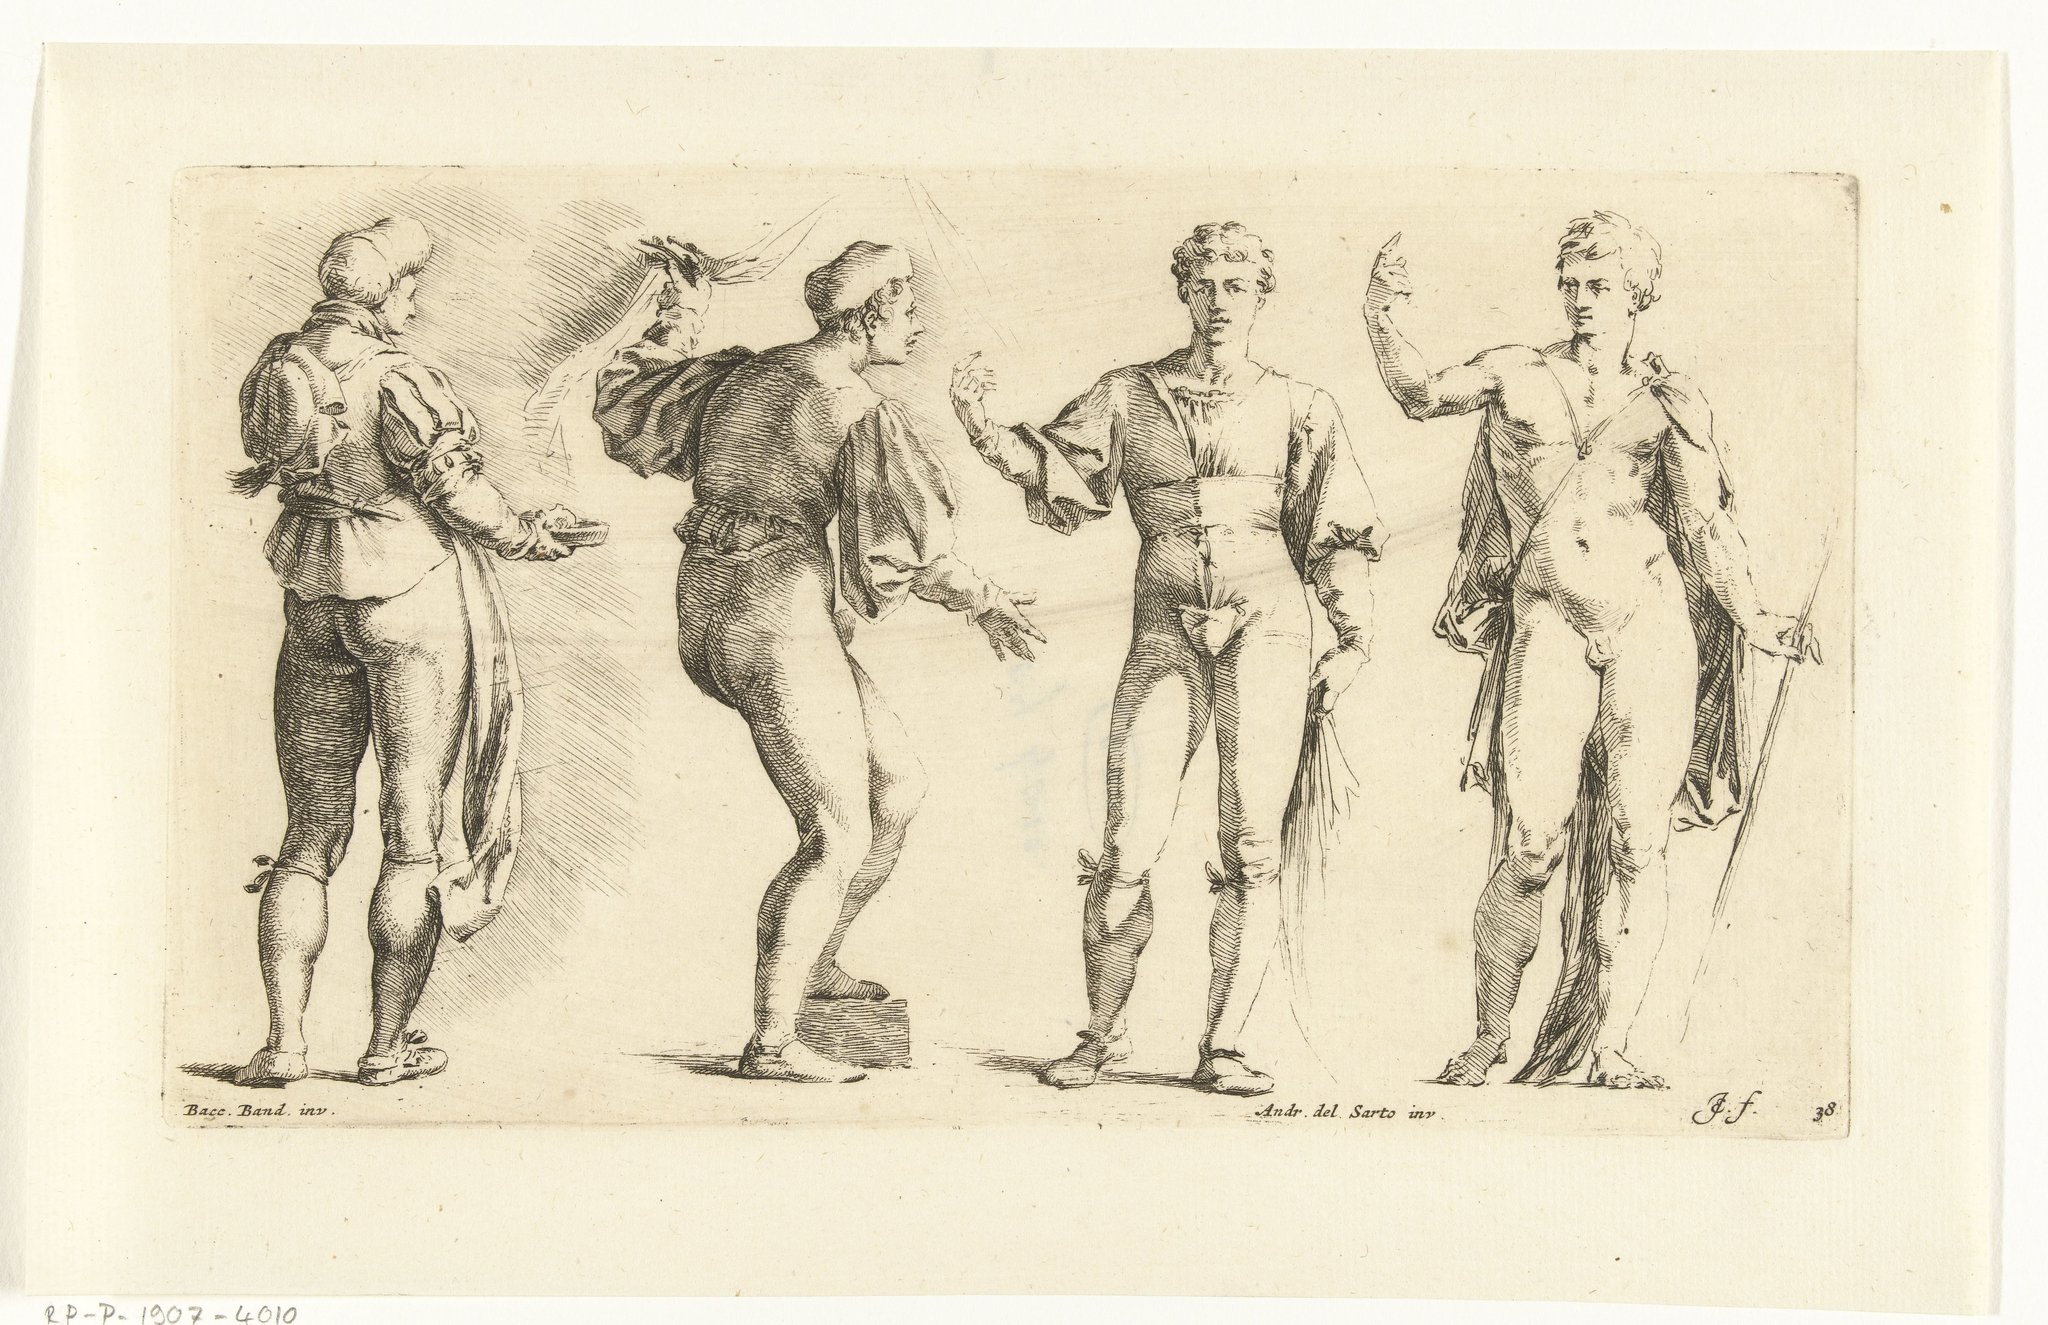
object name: print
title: Vier staande mannen in verschillende houdingen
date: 1668-1671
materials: paper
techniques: etching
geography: northern netherlands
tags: folk costume, regional costume, the soldier; the soldier's life, manservant, footman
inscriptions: collector's mark: Lugt 2228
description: Vier staande mannen: een dienaar op de rug gezien (a), een man die een gordijn omhoog houdt (b), een man in een Florentijns kostuum (c) en een staande krijger met een staf in zijn hand (d).